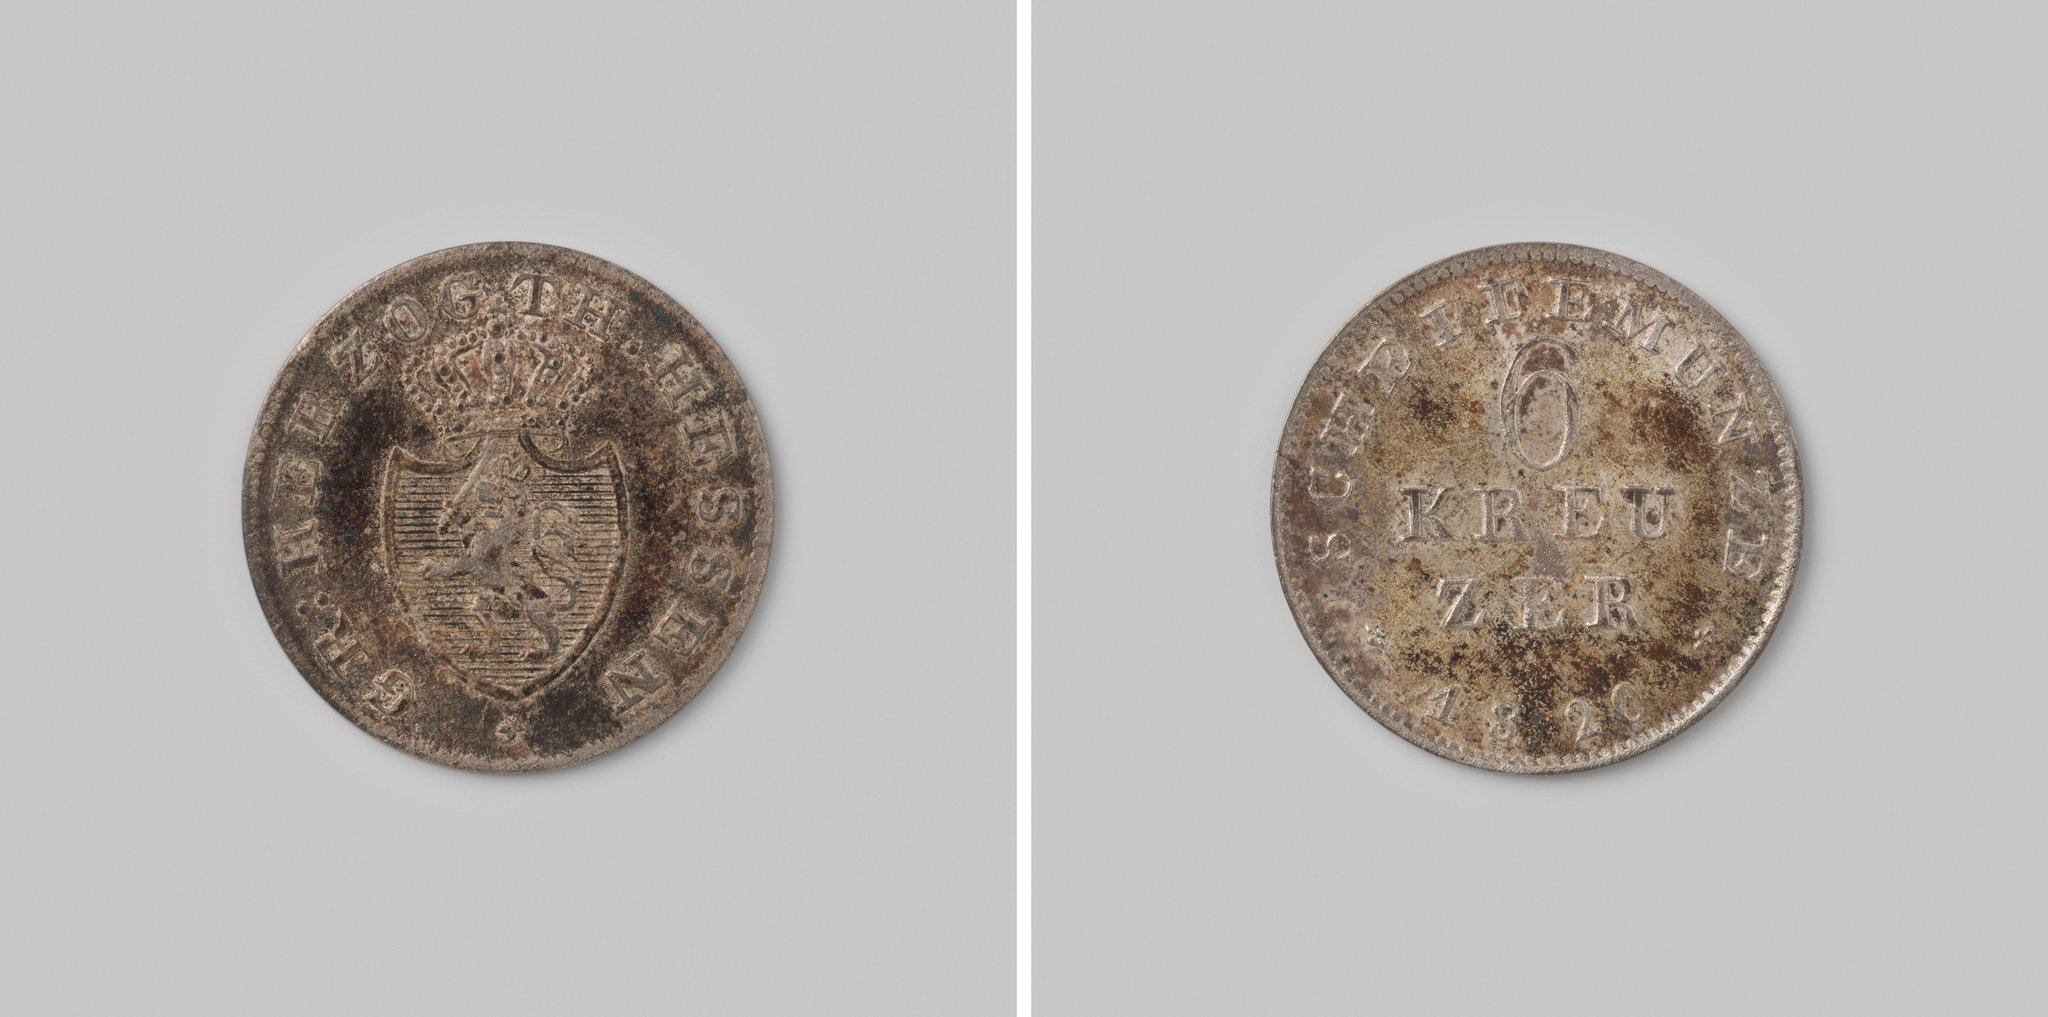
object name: coin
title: Groothertogdom Hessen, Ludwig I, 6 kreuzer, 1820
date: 1820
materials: silver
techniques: striking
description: Zilveren munt. Voorzijde: gekroond wapenschild. Keerzijde: waarde-aanduiding in drie regels, waaronder jaartal in omschrift. Gladde rand.